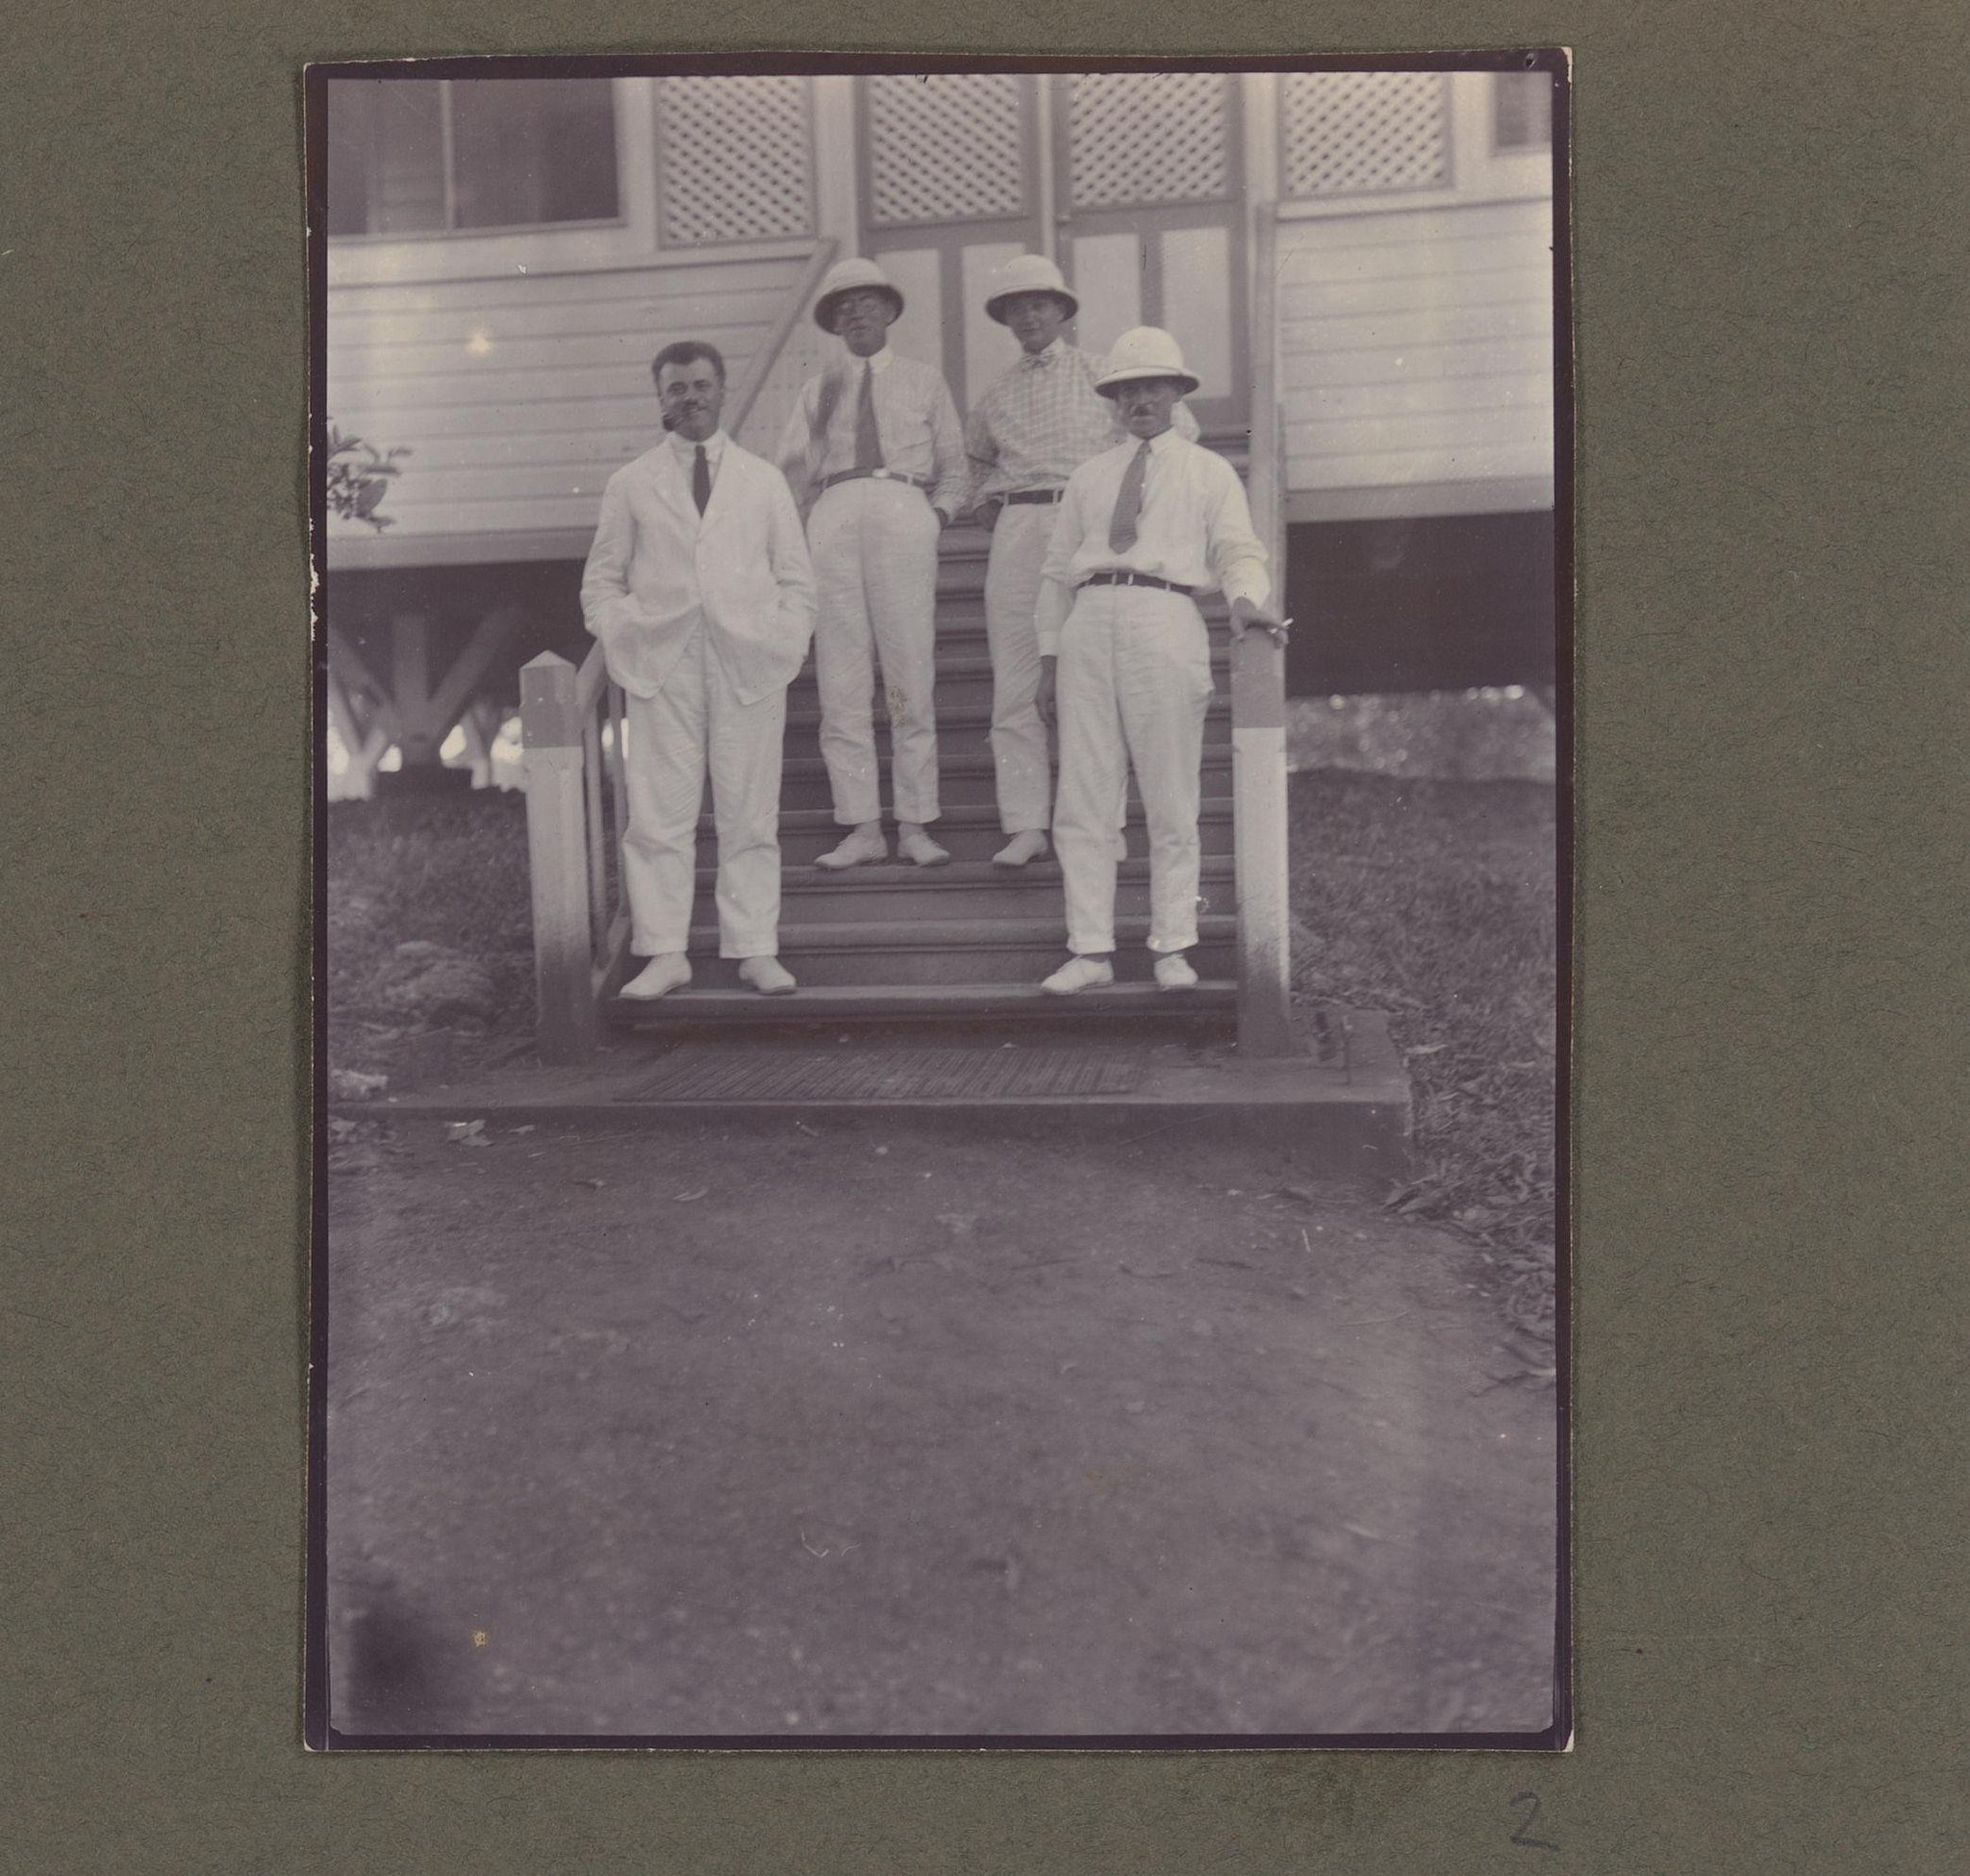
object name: photograph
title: Foto van vier mannen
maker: Anonymous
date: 1925-1927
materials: photographic support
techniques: photography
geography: suriname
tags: jetten, familie, moengo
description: Foto van een groep van vier mannen voor een huis te Moengo, linksboven R.A. Jetten. Foto op een bladzijde van een los albumblad. Onderdeel van het ensemble met foto's van de familie van ingenieur Jetten in de mijnbouwstad Moengo in Suriname.